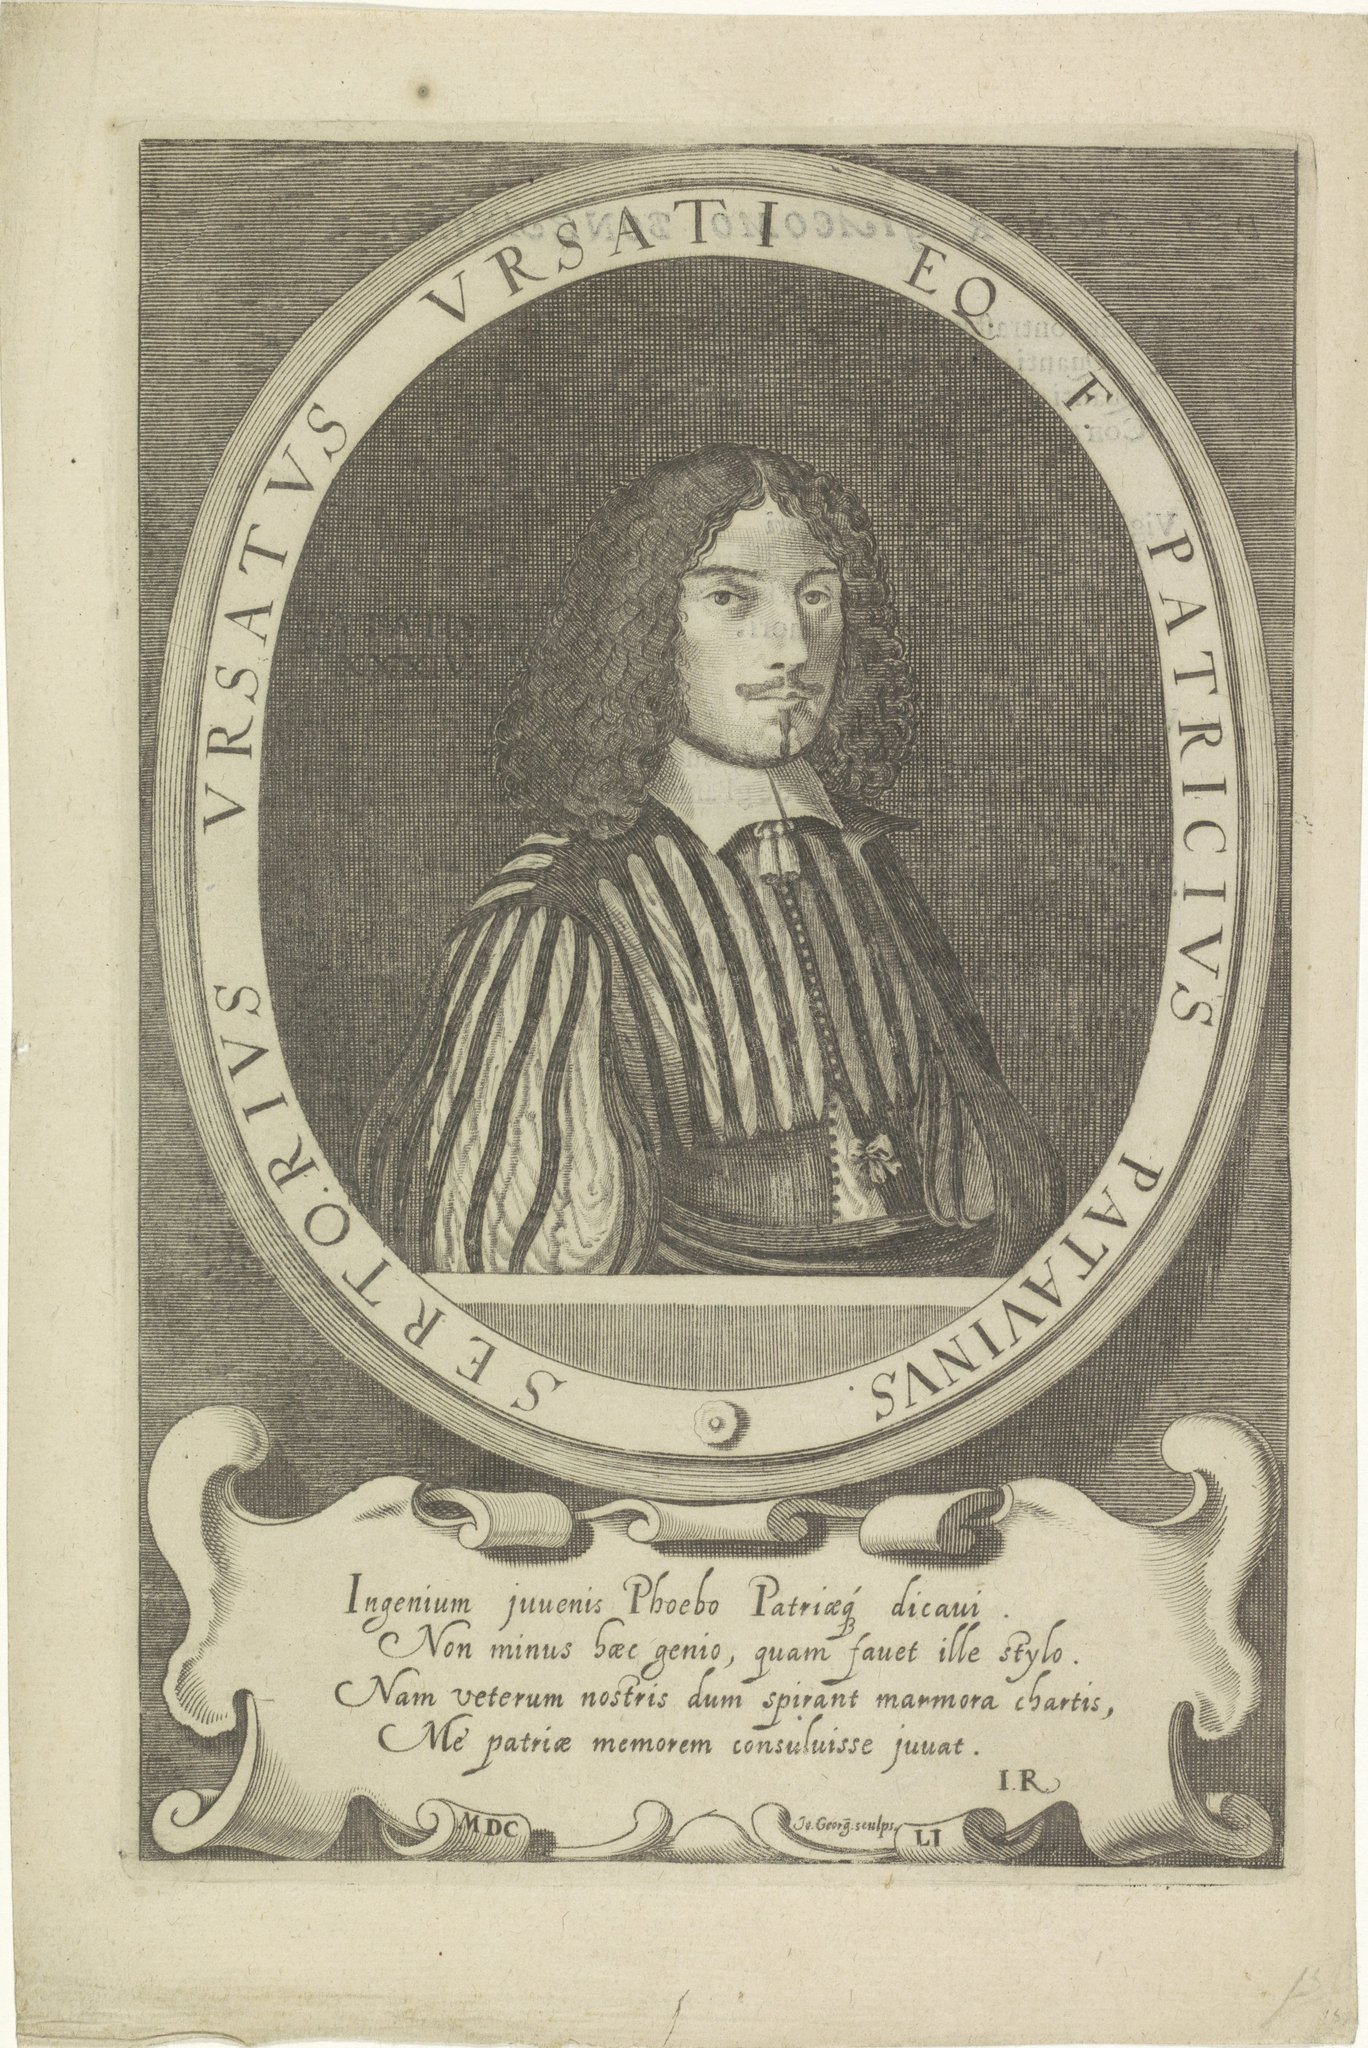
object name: book illustration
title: Portret van Sertorius Ursatus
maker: giovanni georgi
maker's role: print maker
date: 1651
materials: paper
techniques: engraving, letterpress printing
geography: italy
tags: historical persons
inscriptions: collector's mark: Lugt 2228